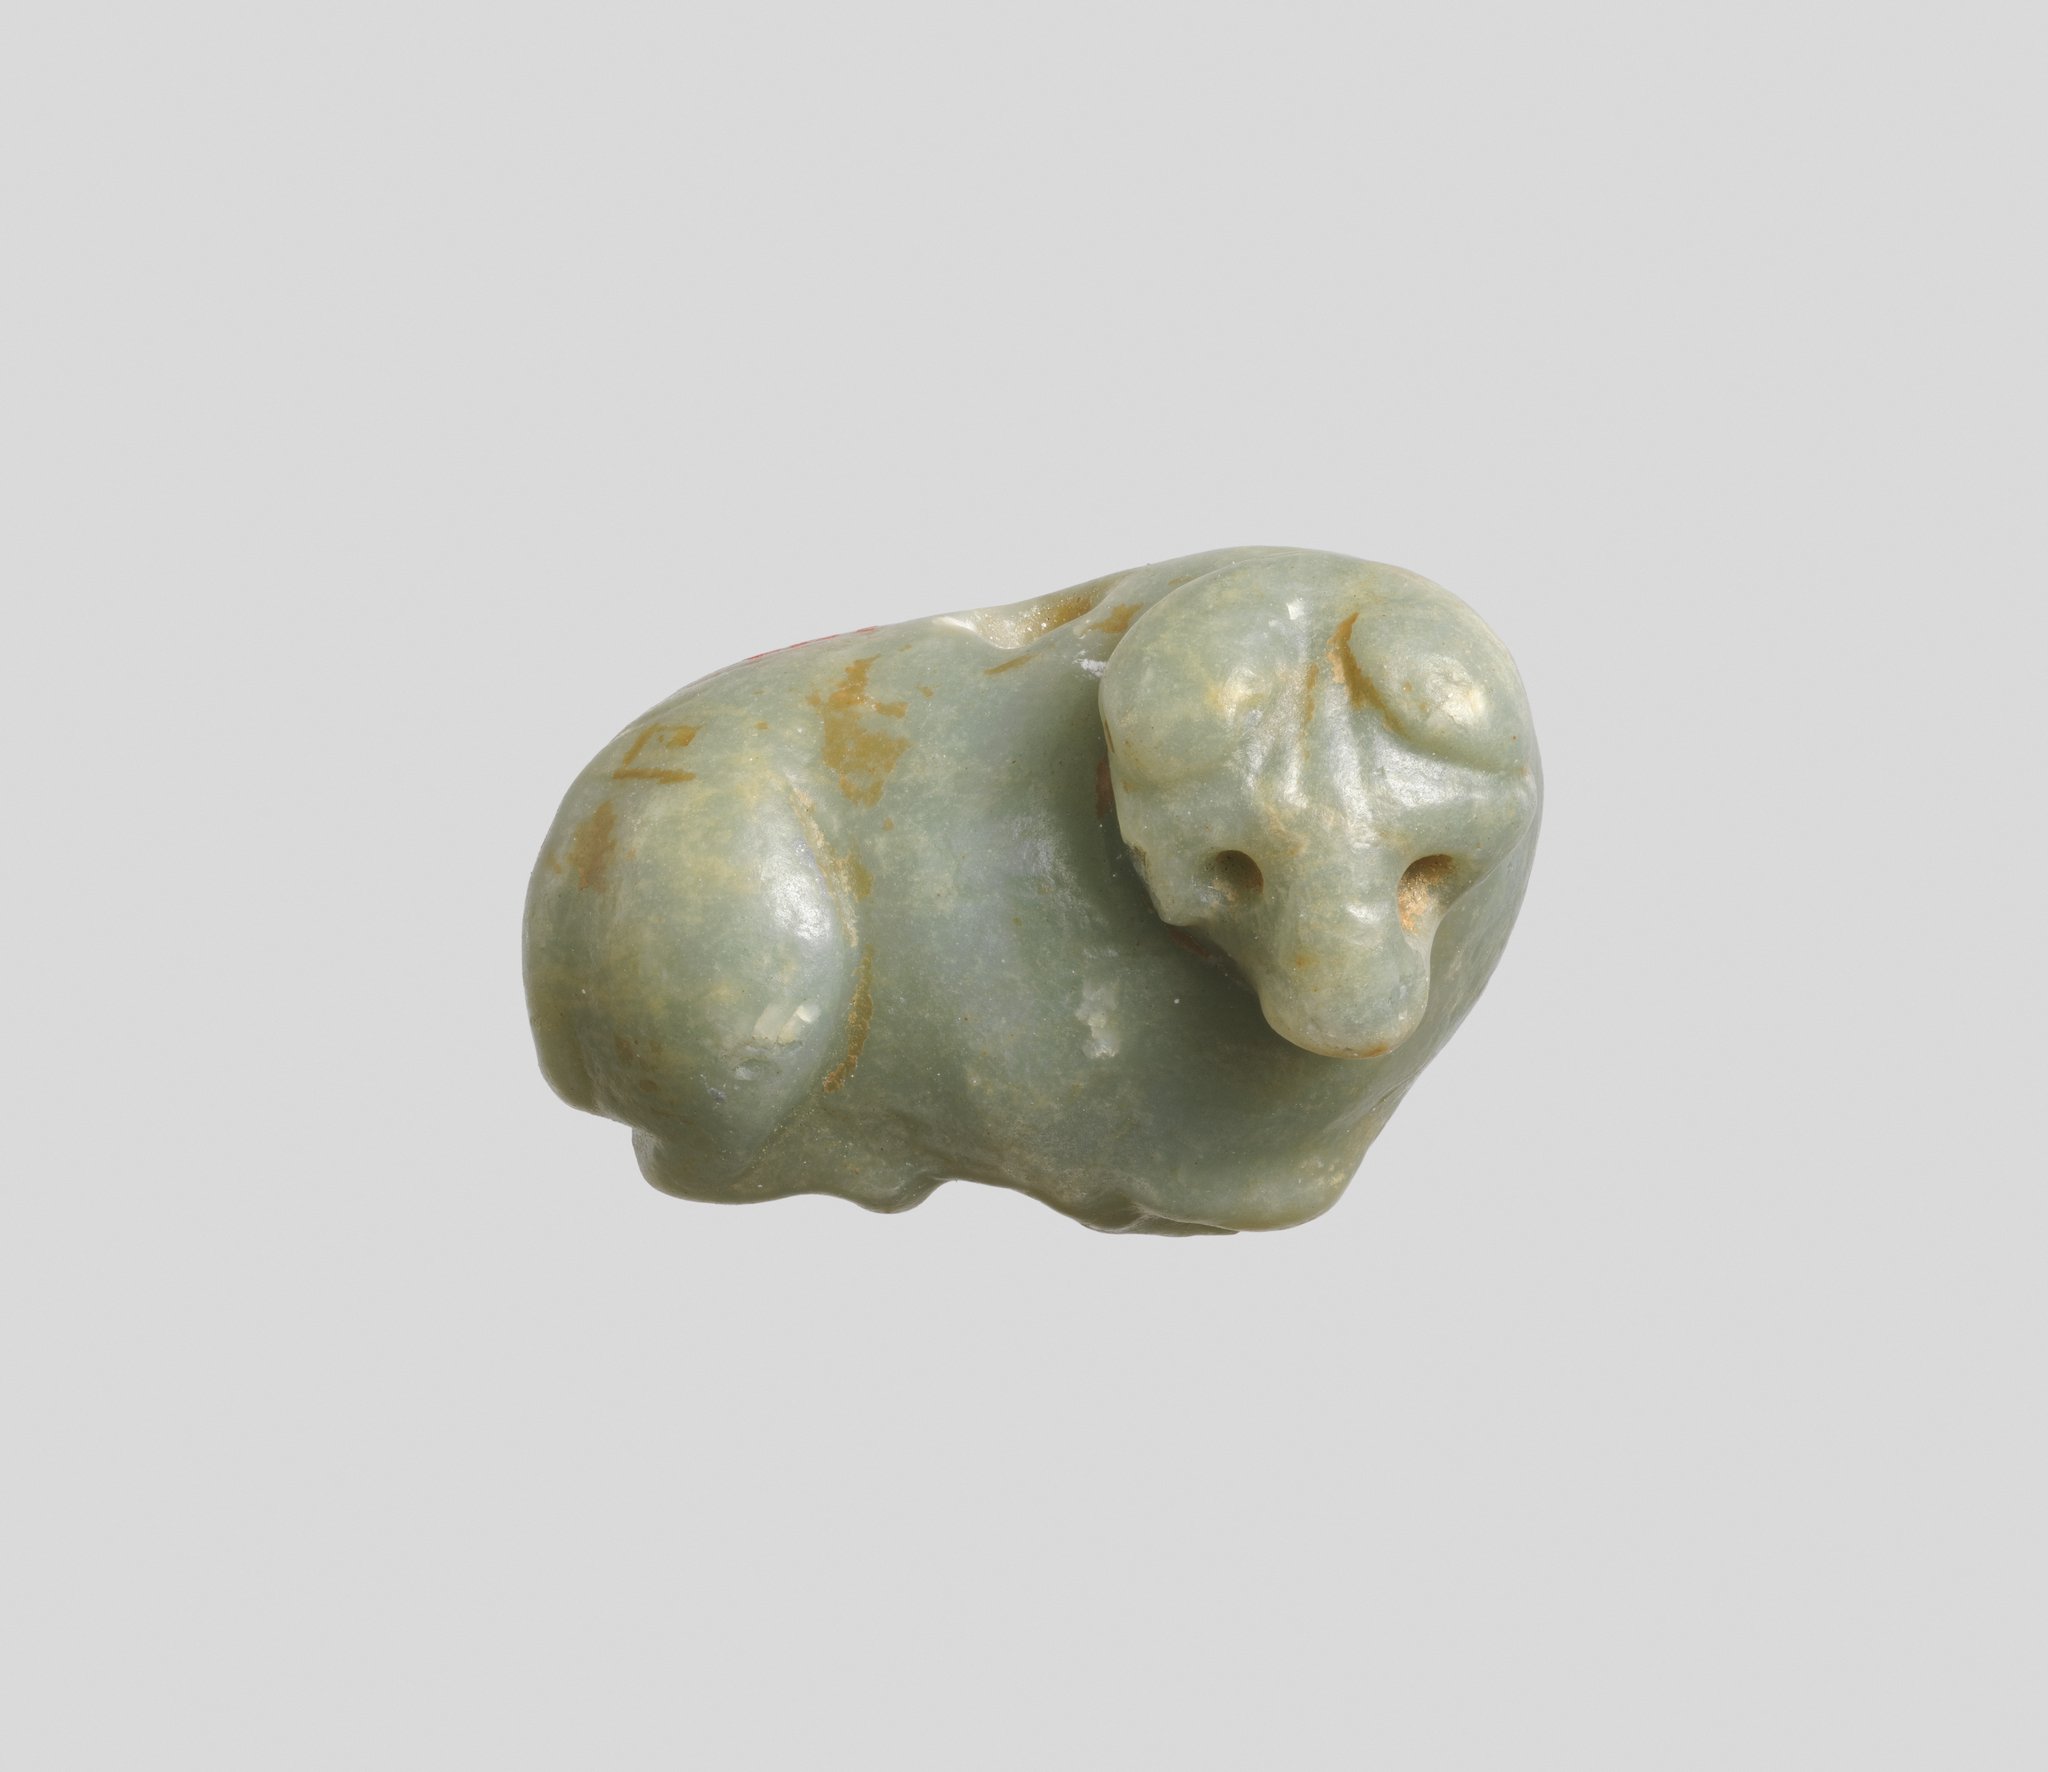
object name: stamp seal amulet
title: Seal amulet in the form of a recumbent bovid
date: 3500-2900 BCE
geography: iran or mesopotamia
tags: animals